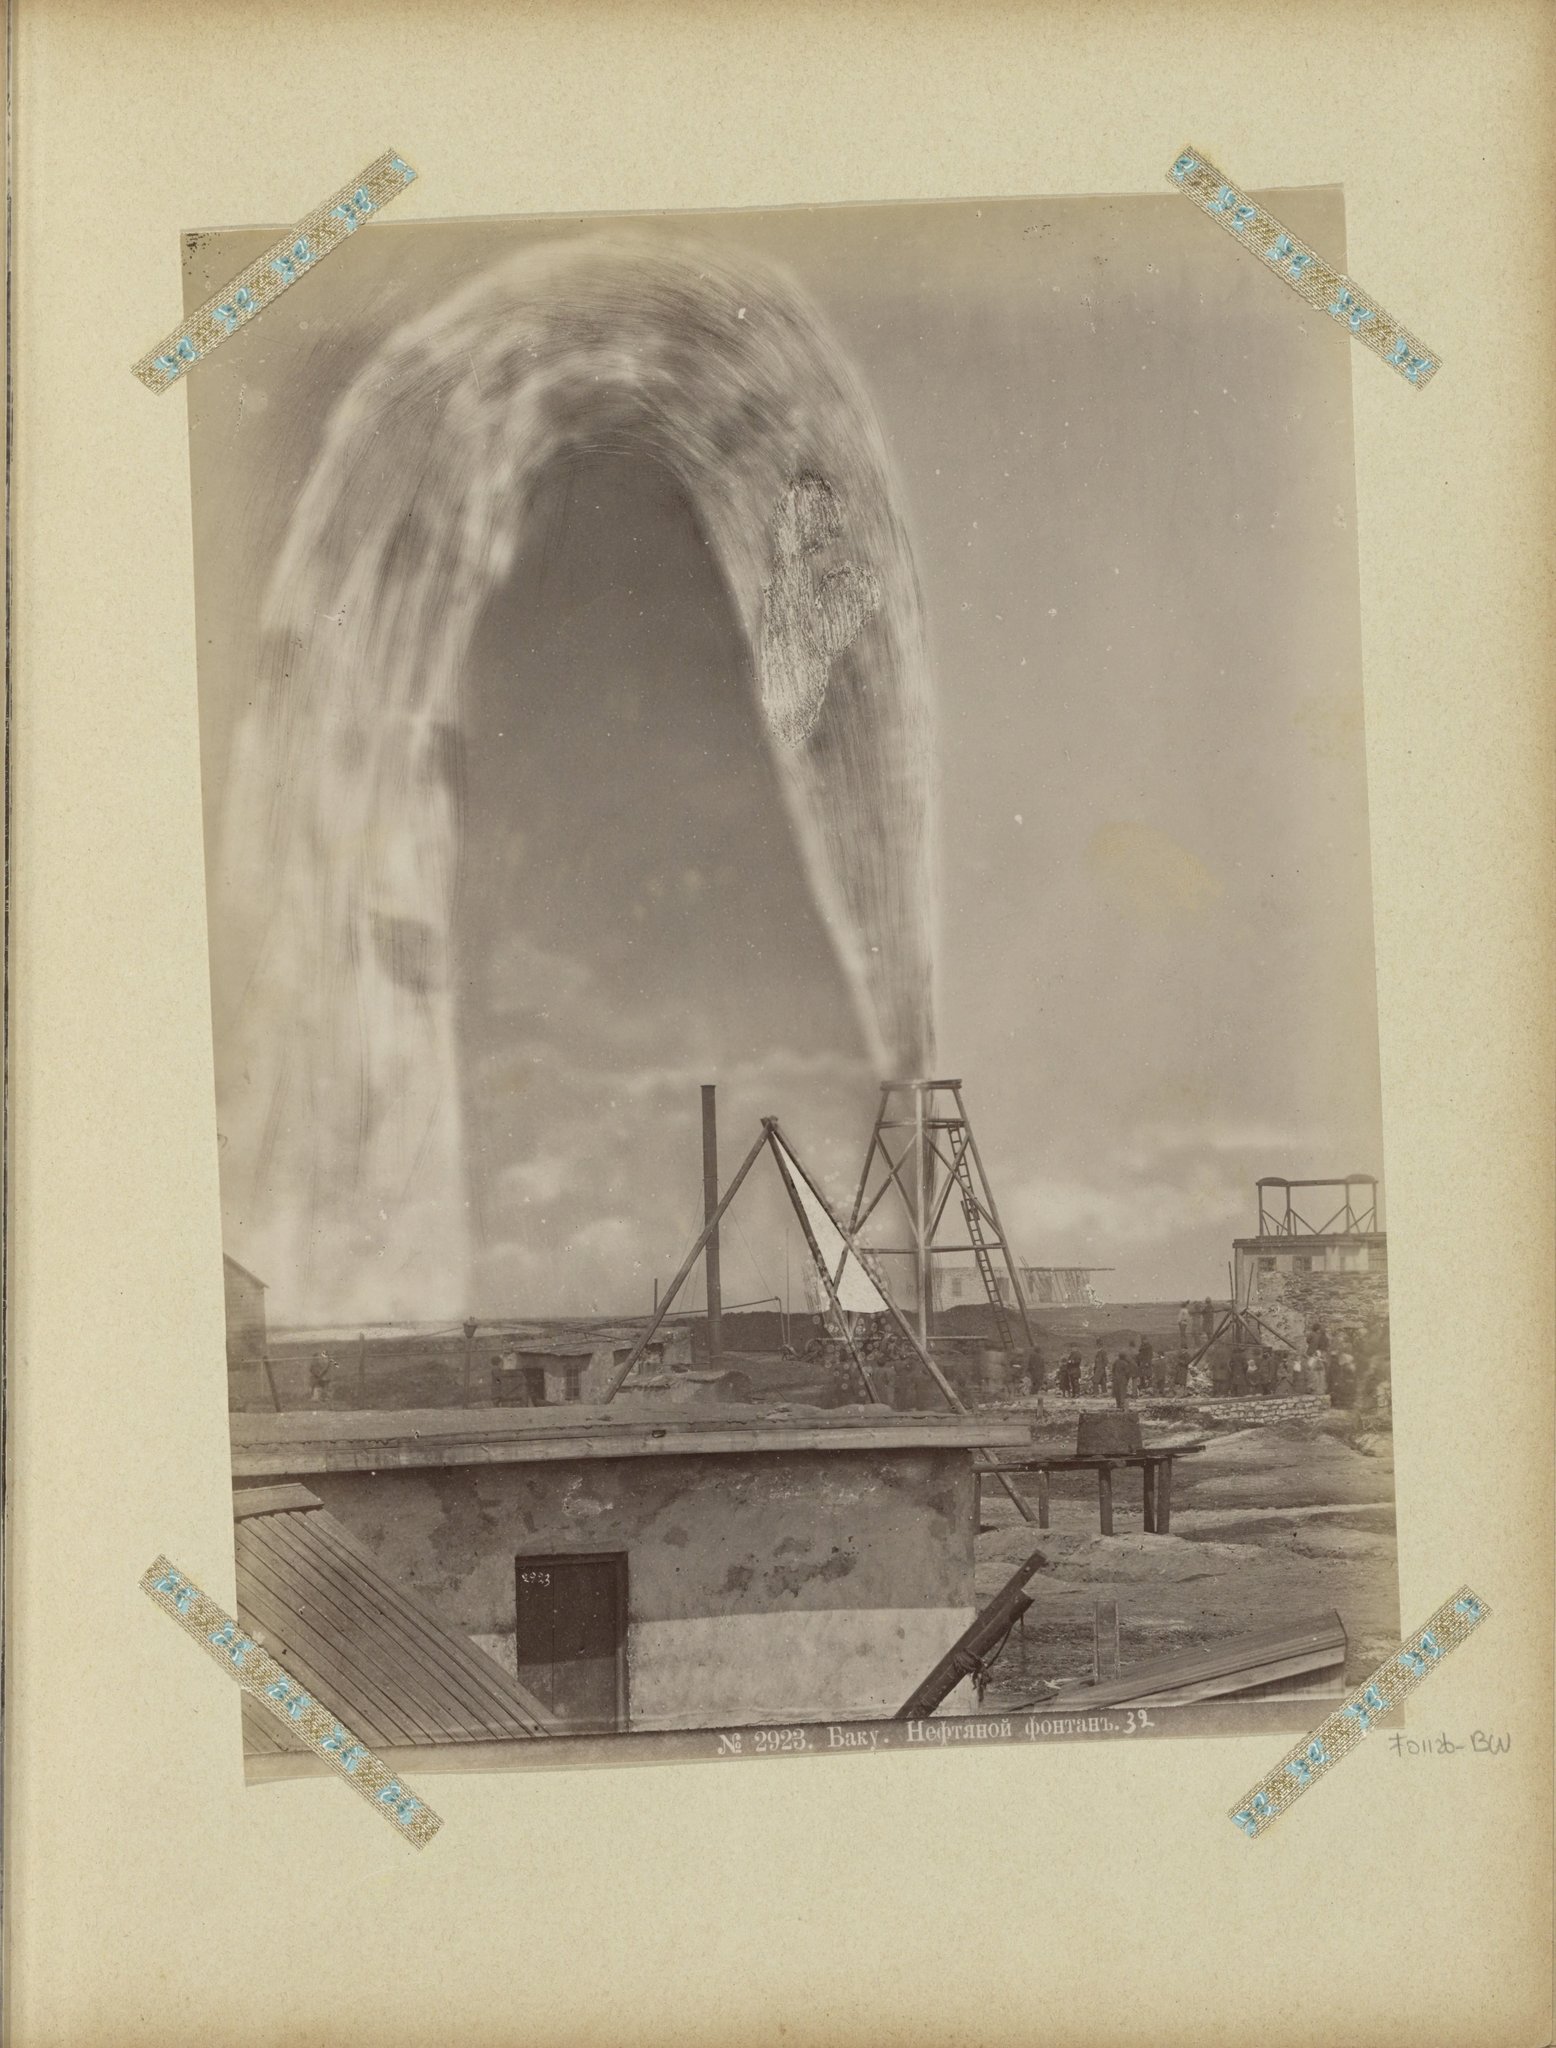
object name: photograph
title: Njoftjanja fontan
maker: Anonymous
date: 1890-1900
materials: photographic support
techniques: albumen print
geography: baku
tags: derrick ~ oil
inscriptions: number: ‘2923’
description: De spuitende oliefontein op de foto is niet realistisch en vermoedelijk door retouches aangebracht.